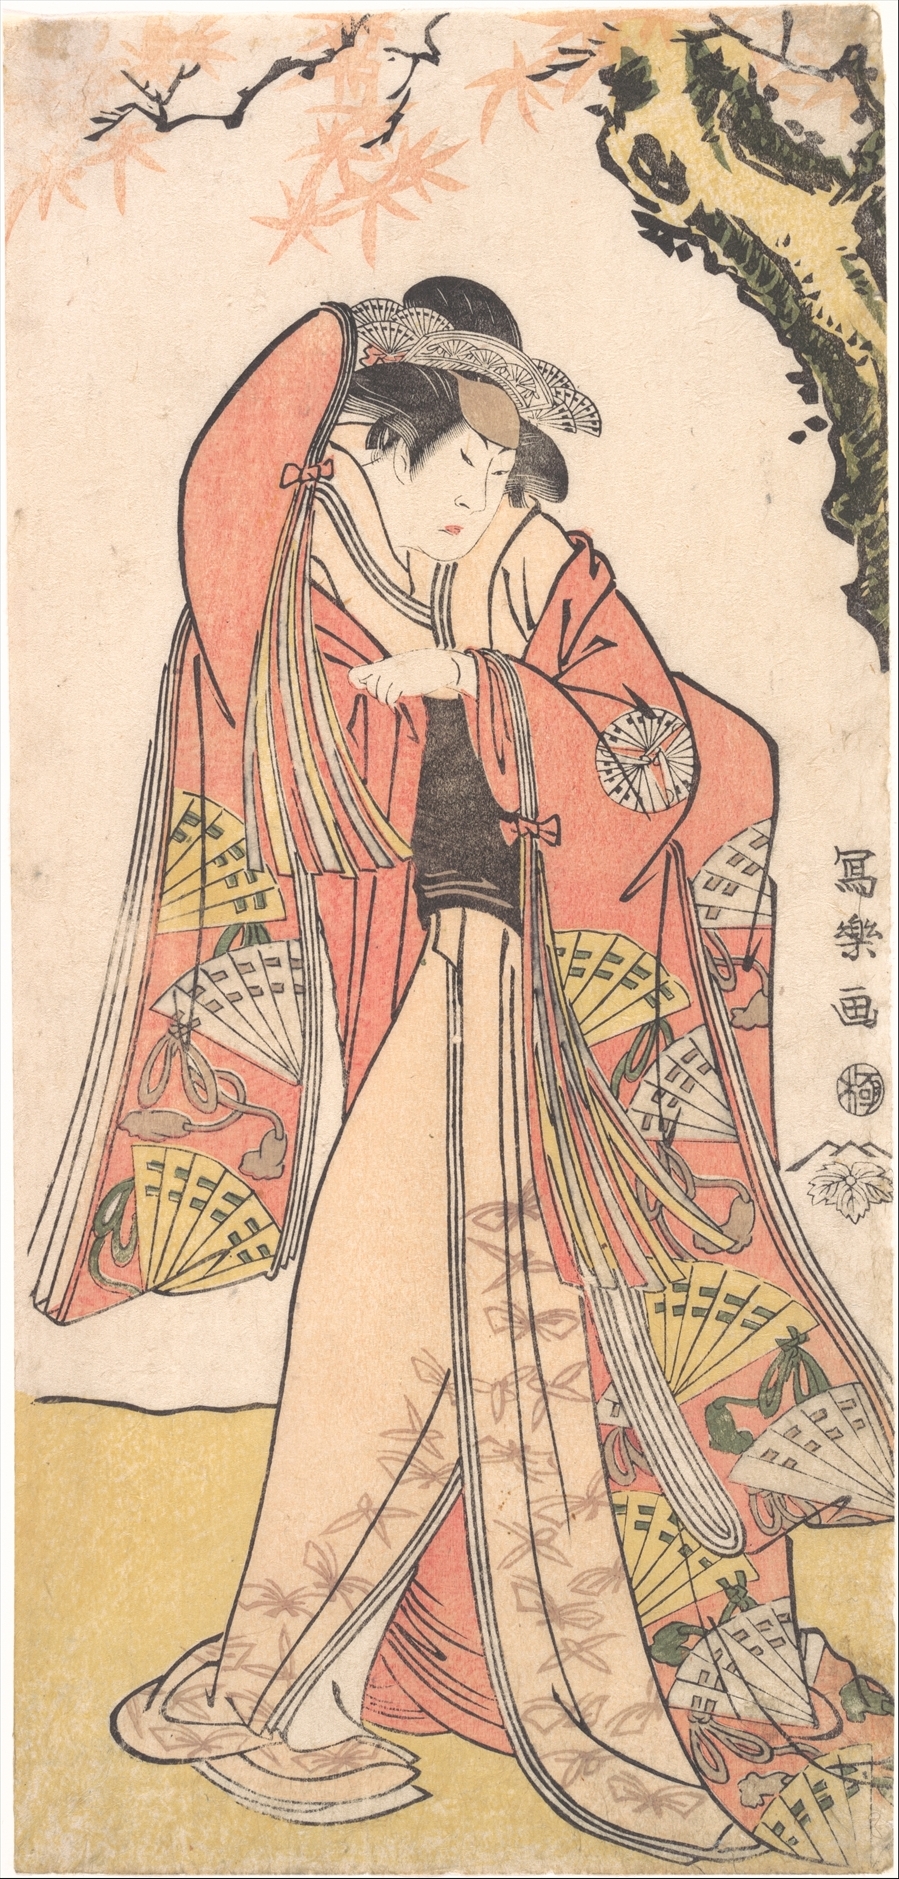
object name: print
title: Actor Sakakiyama Sangoro II as Michinaga's Daughter Princess Otae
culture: japanese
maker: tōshūsai sharaku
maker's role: artist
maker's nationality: japanese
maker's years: 1794-1795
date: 1794-1795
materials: ink, paper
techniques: woodblock print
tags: men,women,actors